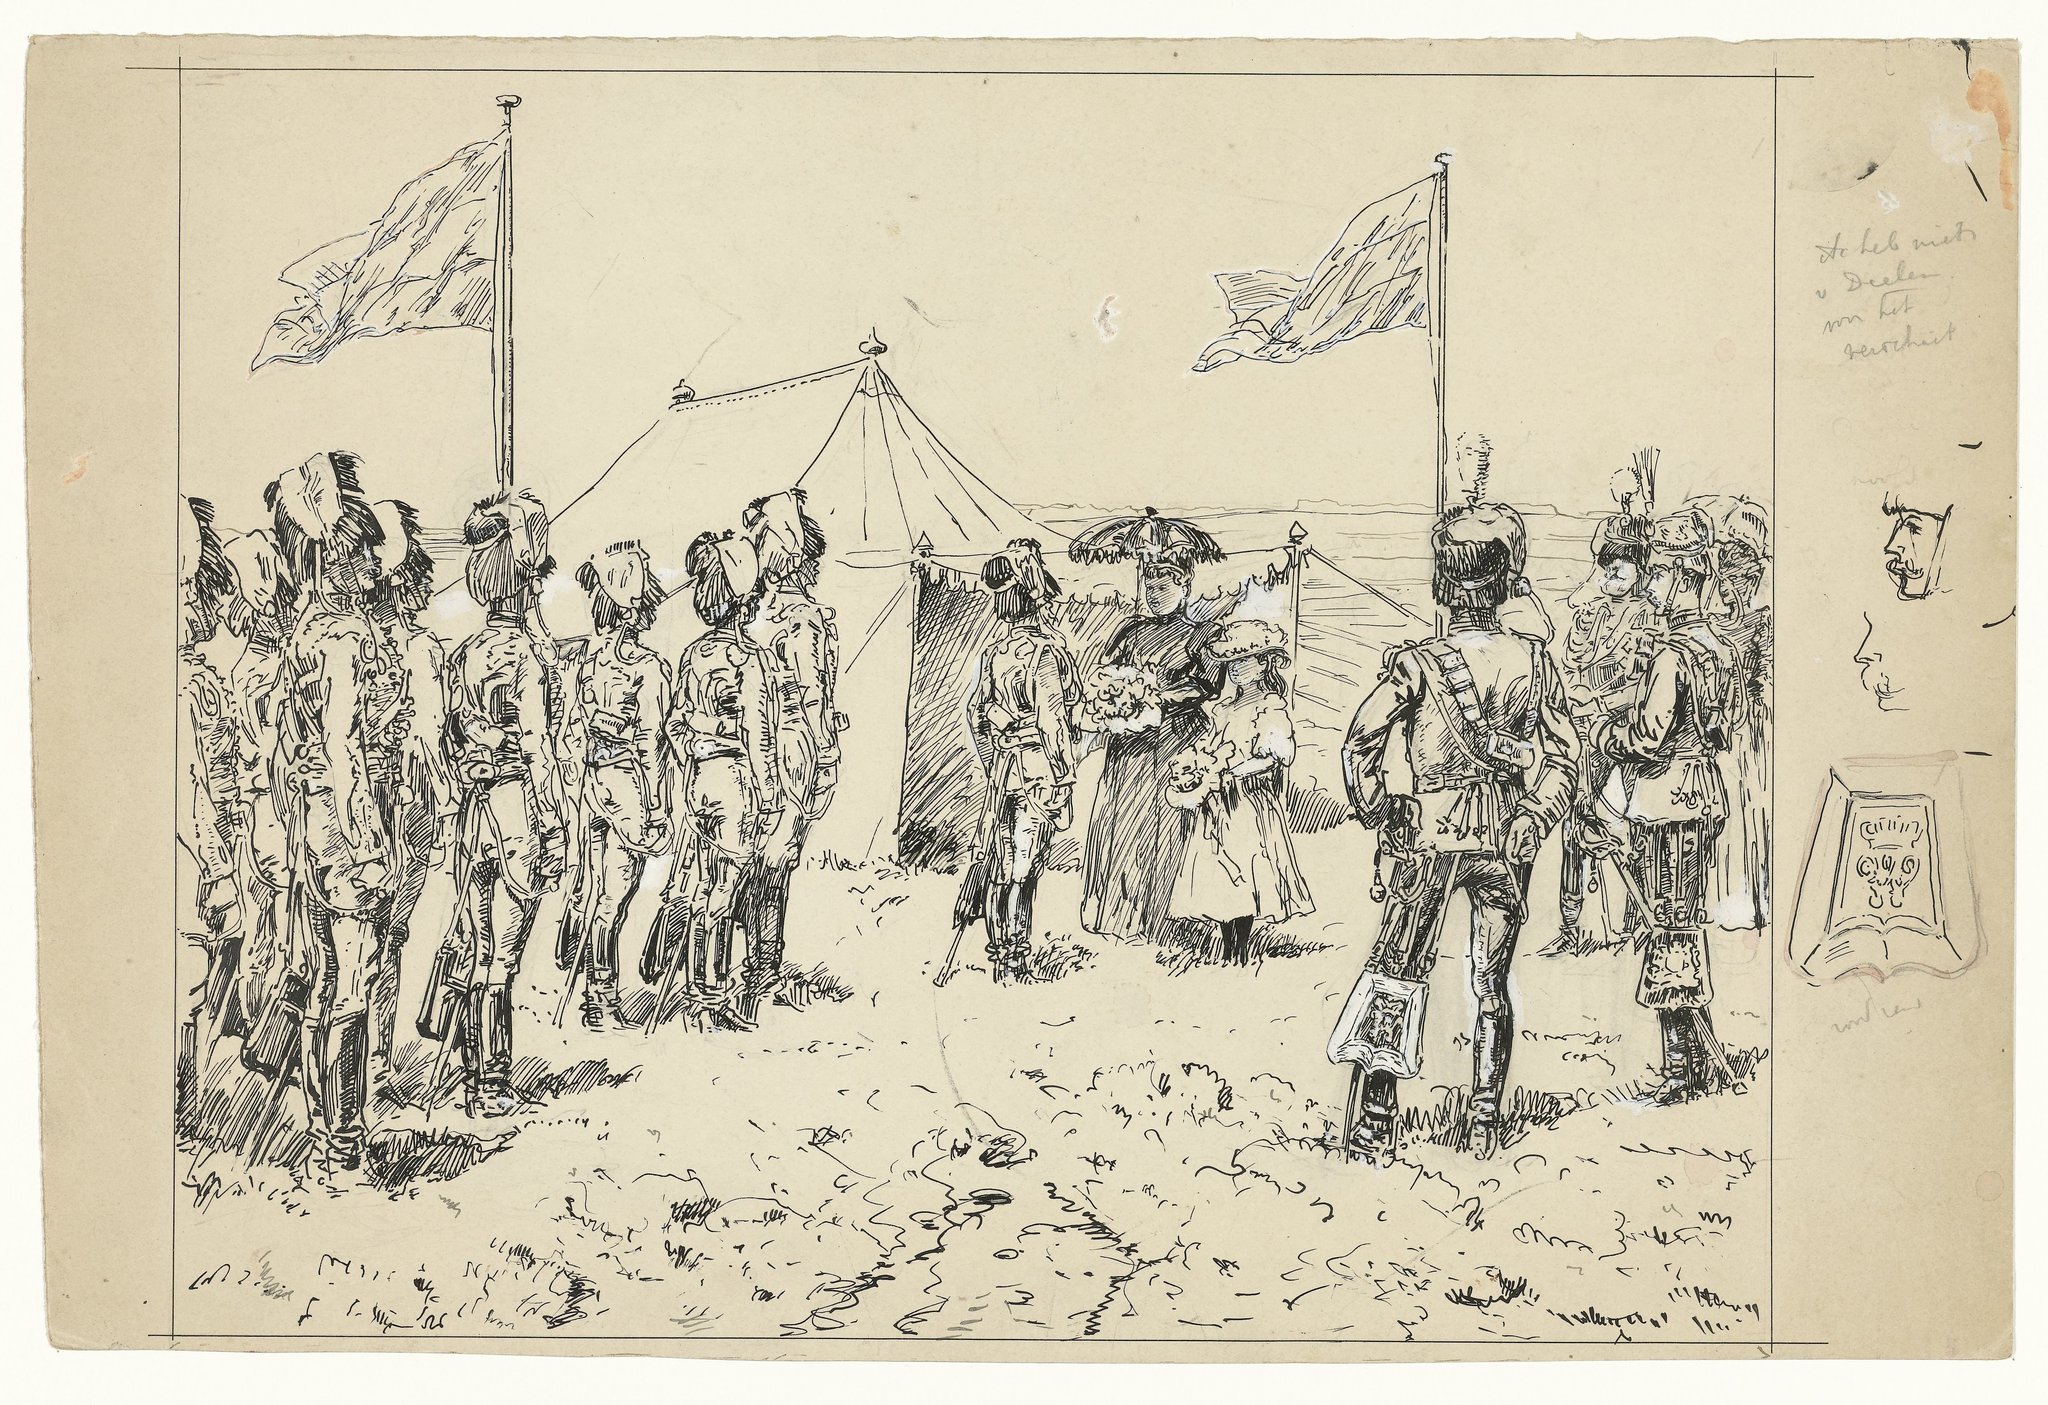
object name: drawing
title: Koningin Emma met prinses Wilhelmina bij een militaire oefening op de Kempenbergerheide, 1893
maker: jan hoynck van papendrecht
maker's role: draughtsman, painter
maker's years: 1858-1933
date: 1893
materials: paint, ink, paper, pencil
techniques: pen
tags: the hague, print maker, wilhelmina of the netherlands, emma (queen consort of the netherlands), military training (+ cavalry, horsemen), historical persons